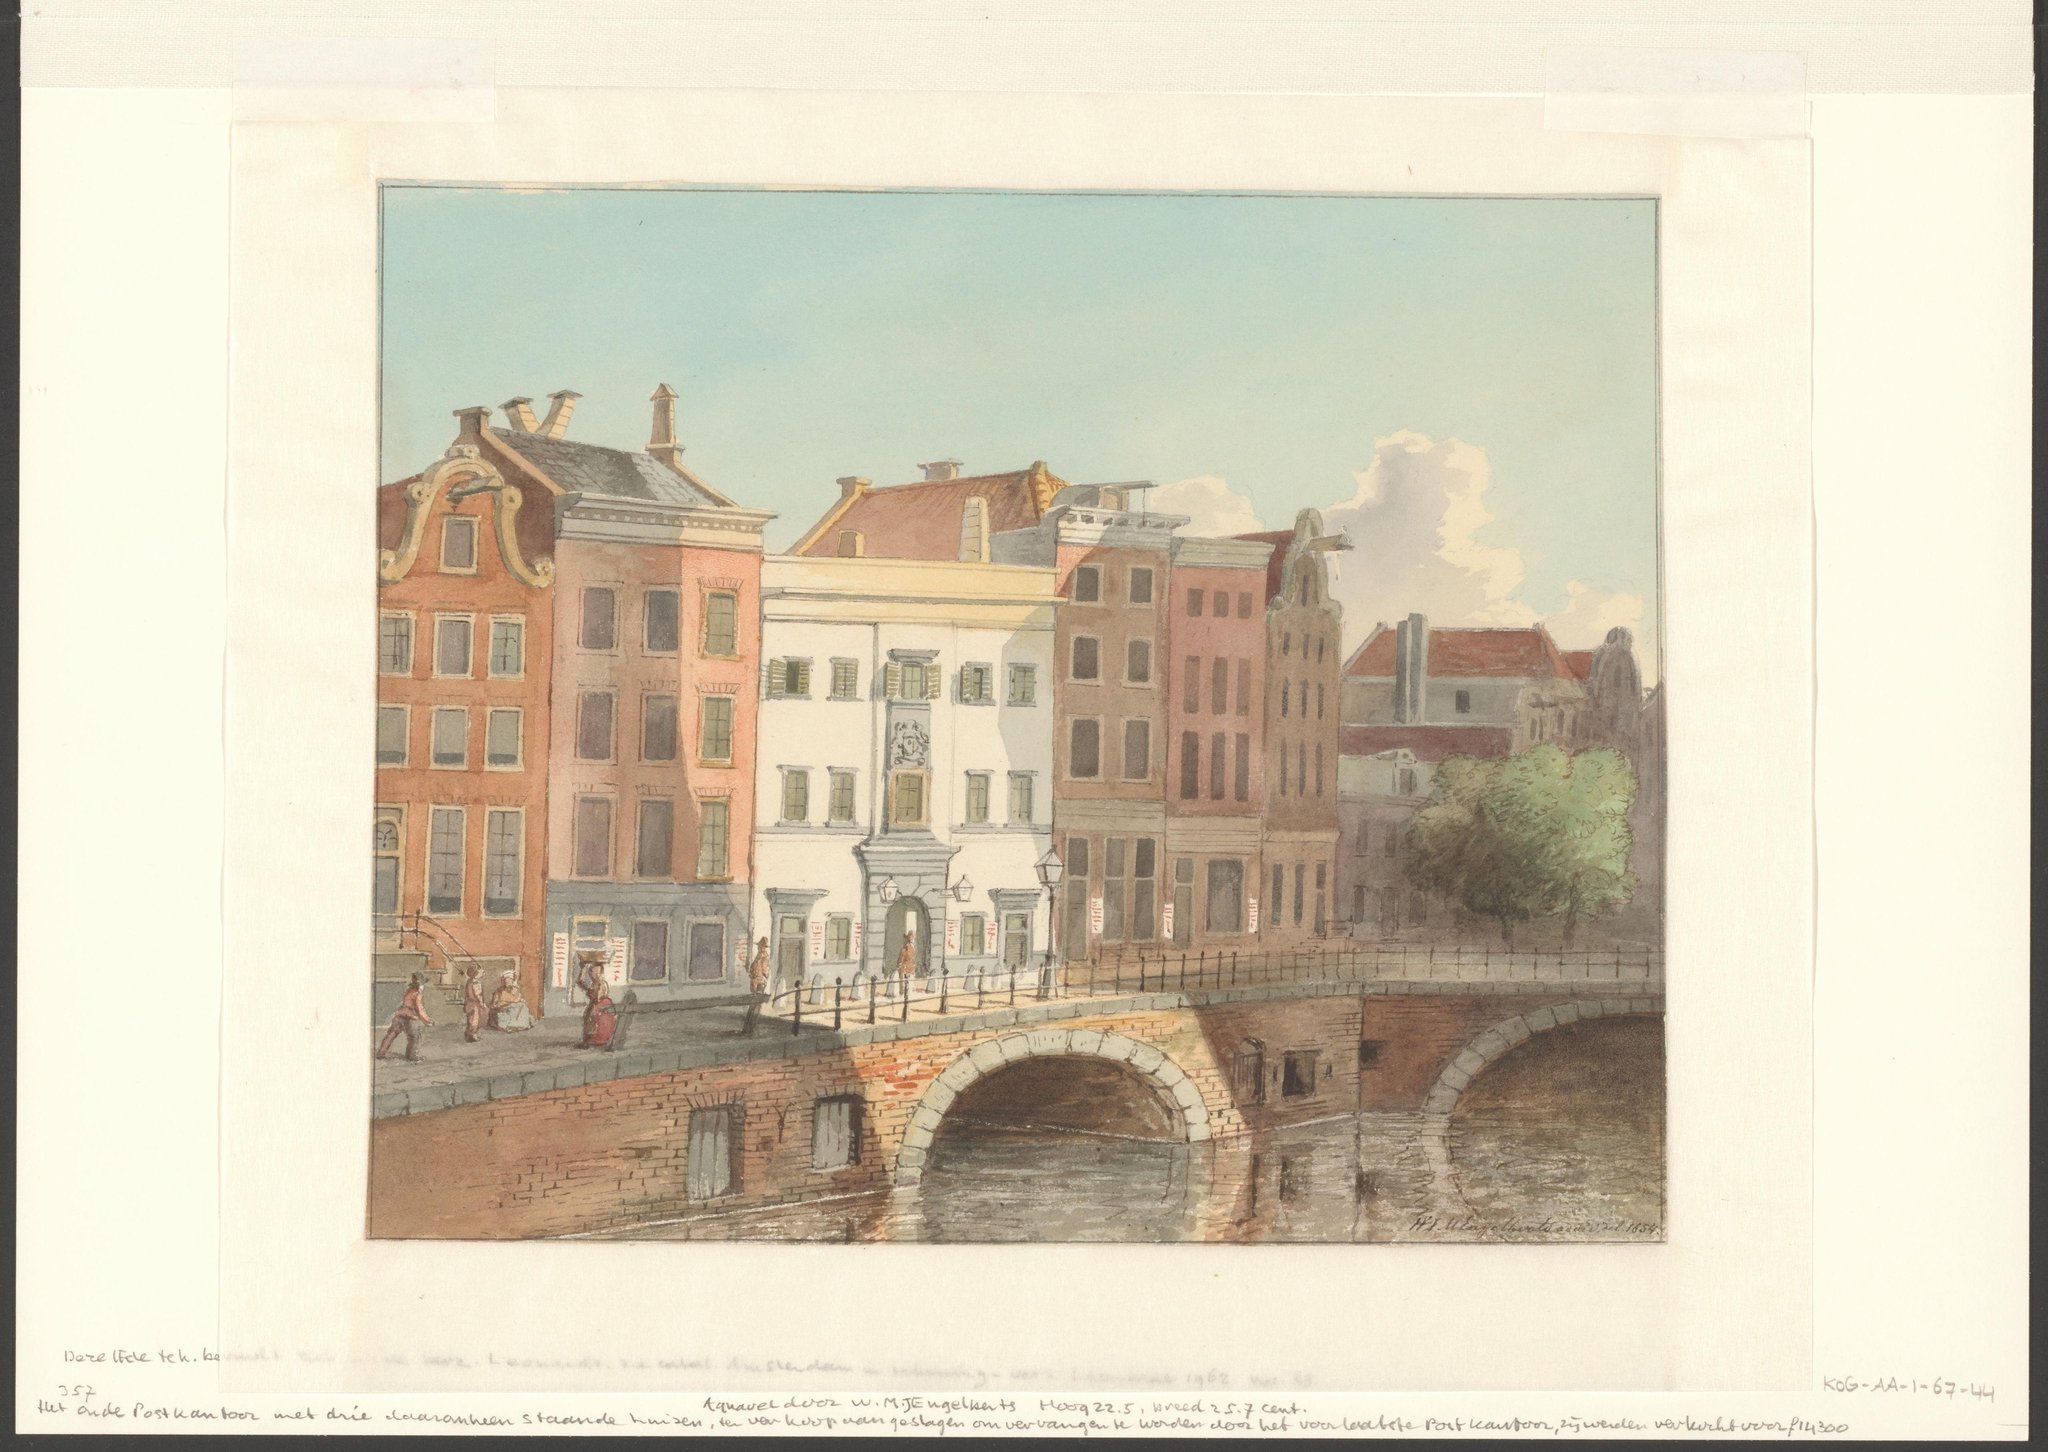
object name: drawing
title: Gezicht op de Nieuwezijds Voorburgwal met het oude postkantoor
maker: willem jodocus mattheus engelberts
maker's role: draughtsman, print maker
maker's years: 1809-1887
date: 1854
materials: ink, paper, pencil, watercolor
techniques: brush, pen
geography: amsterdam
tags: post-office, city-view in general; 'veduta', canal, bridge in city across river, canal, etc., street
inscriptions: signature and date: ‘WJM Engelberts ad viv del 1854.’, inscription: ‘Dezelde tek. bevindt (...) verkocht voor f14300’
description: Onderwerpsrubriek binnen de Atlas Amsterdam: Posterijen en telegrafie.